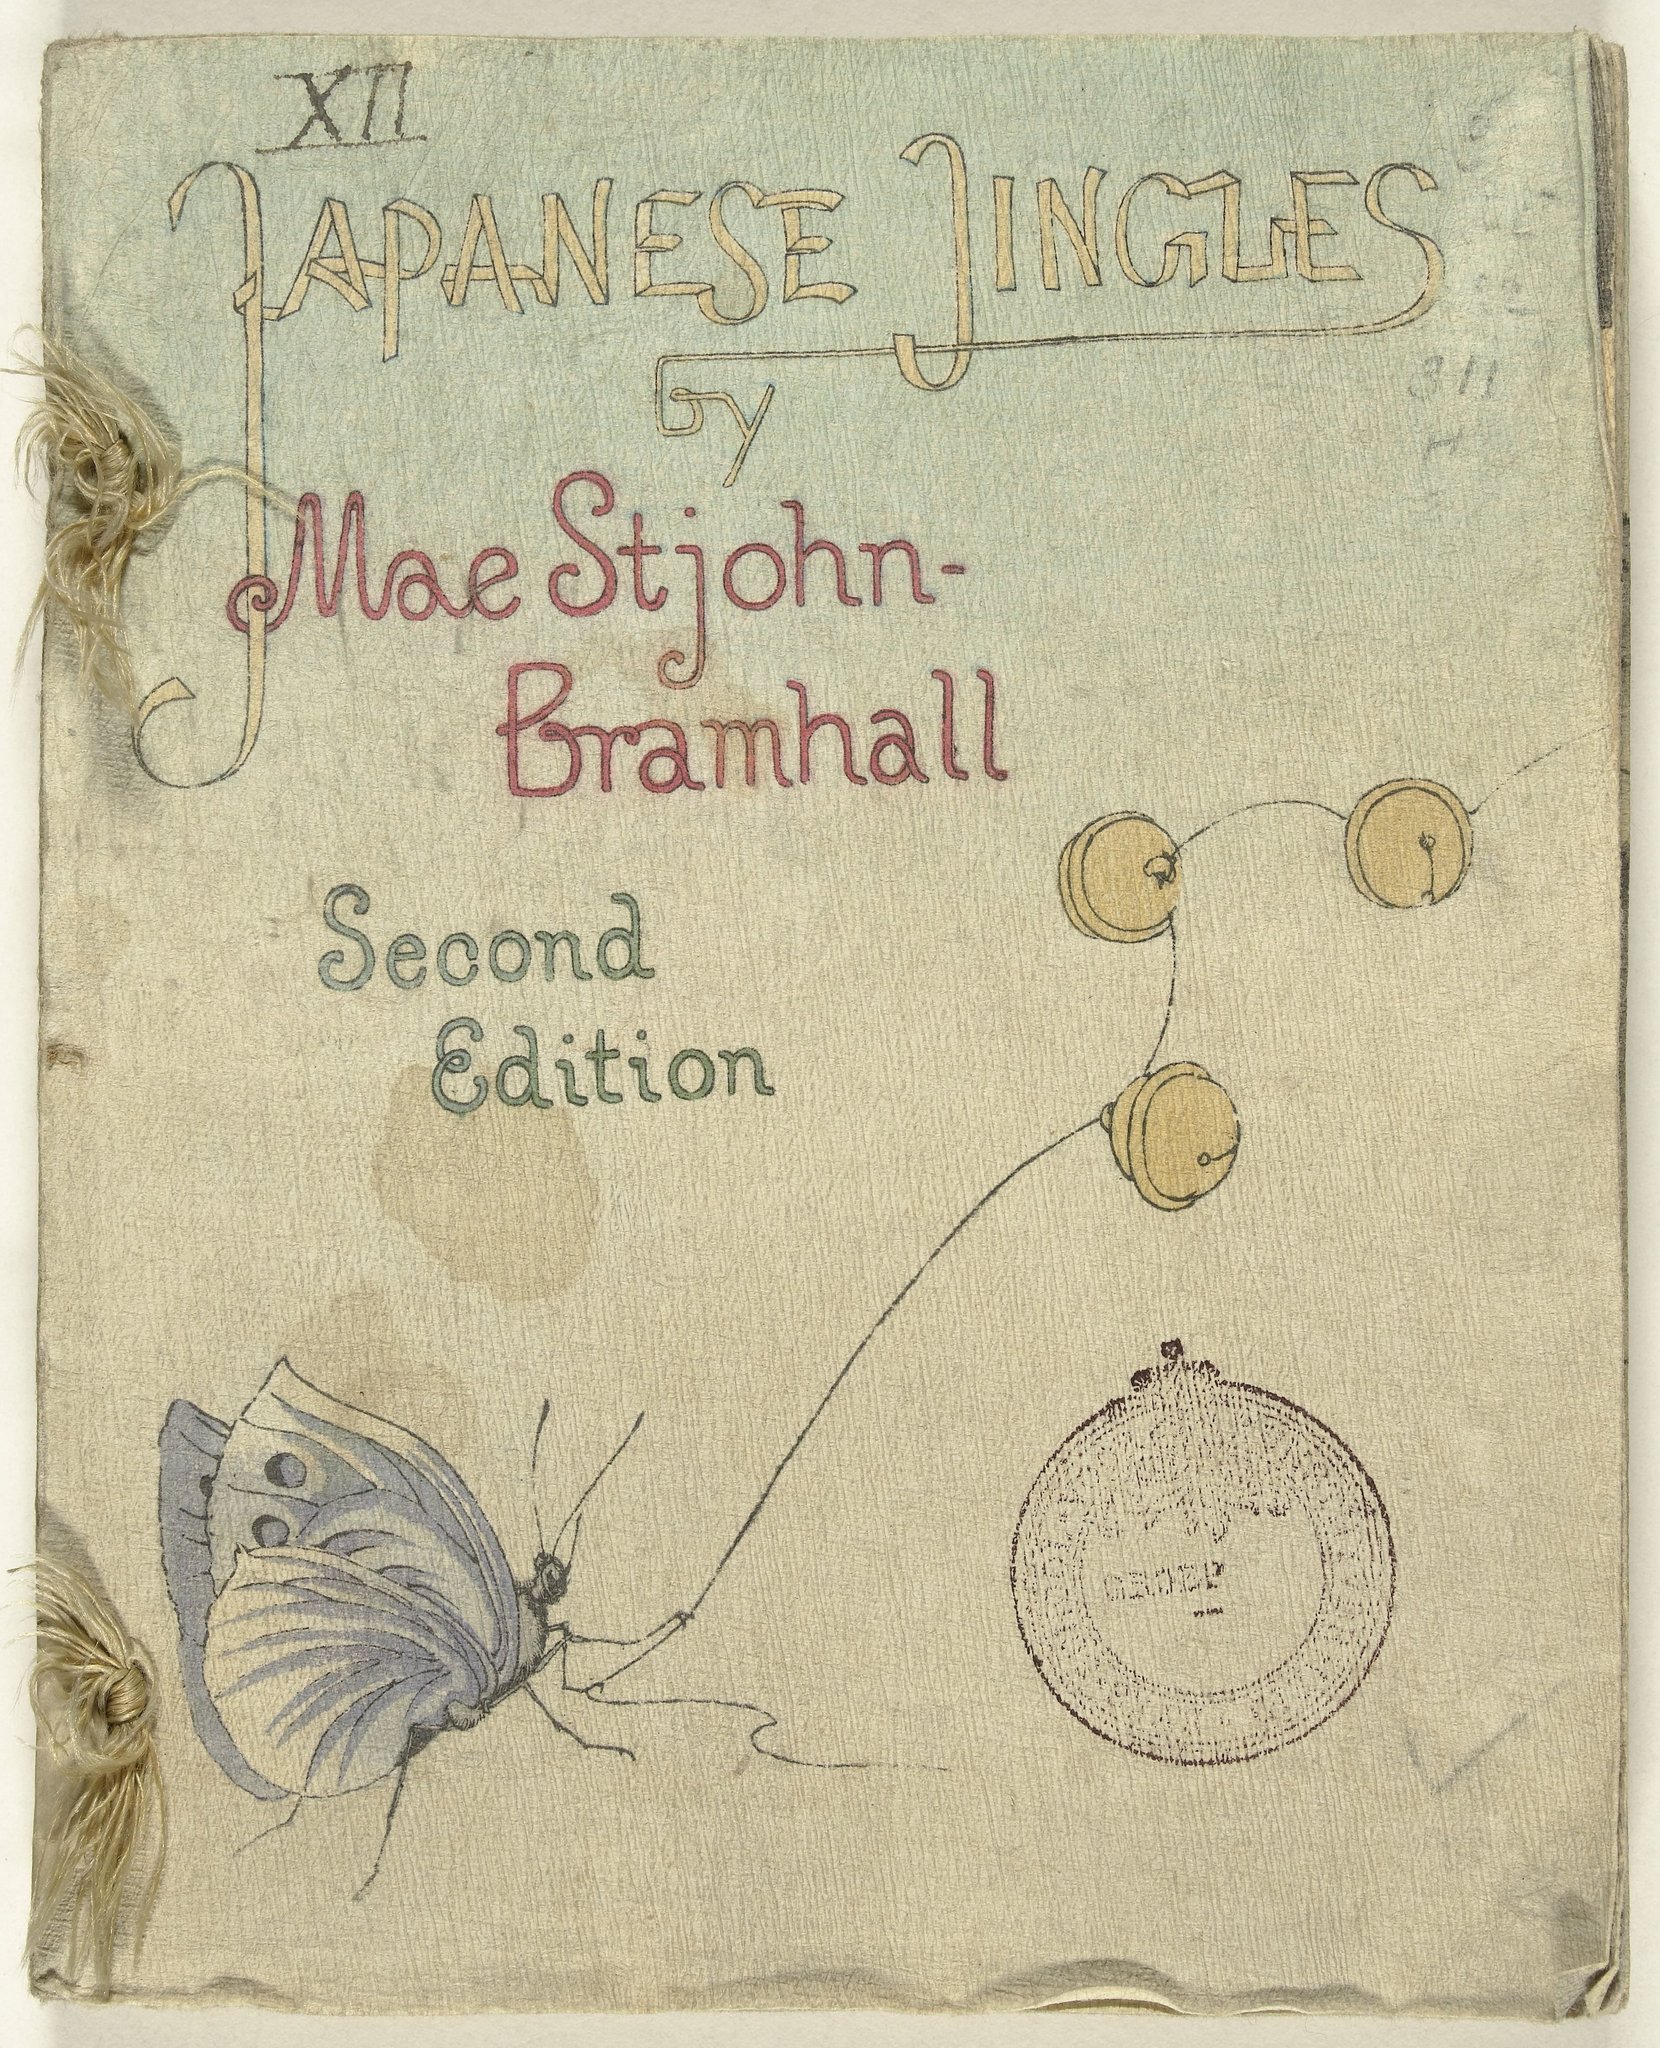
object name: book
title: Japanese Jingles - second edition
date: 1893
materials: paper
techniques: woodcut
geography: tokyo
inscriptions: collector's mark: ‘Rijksschool voor kunstnijverheid’ Lugt 3937